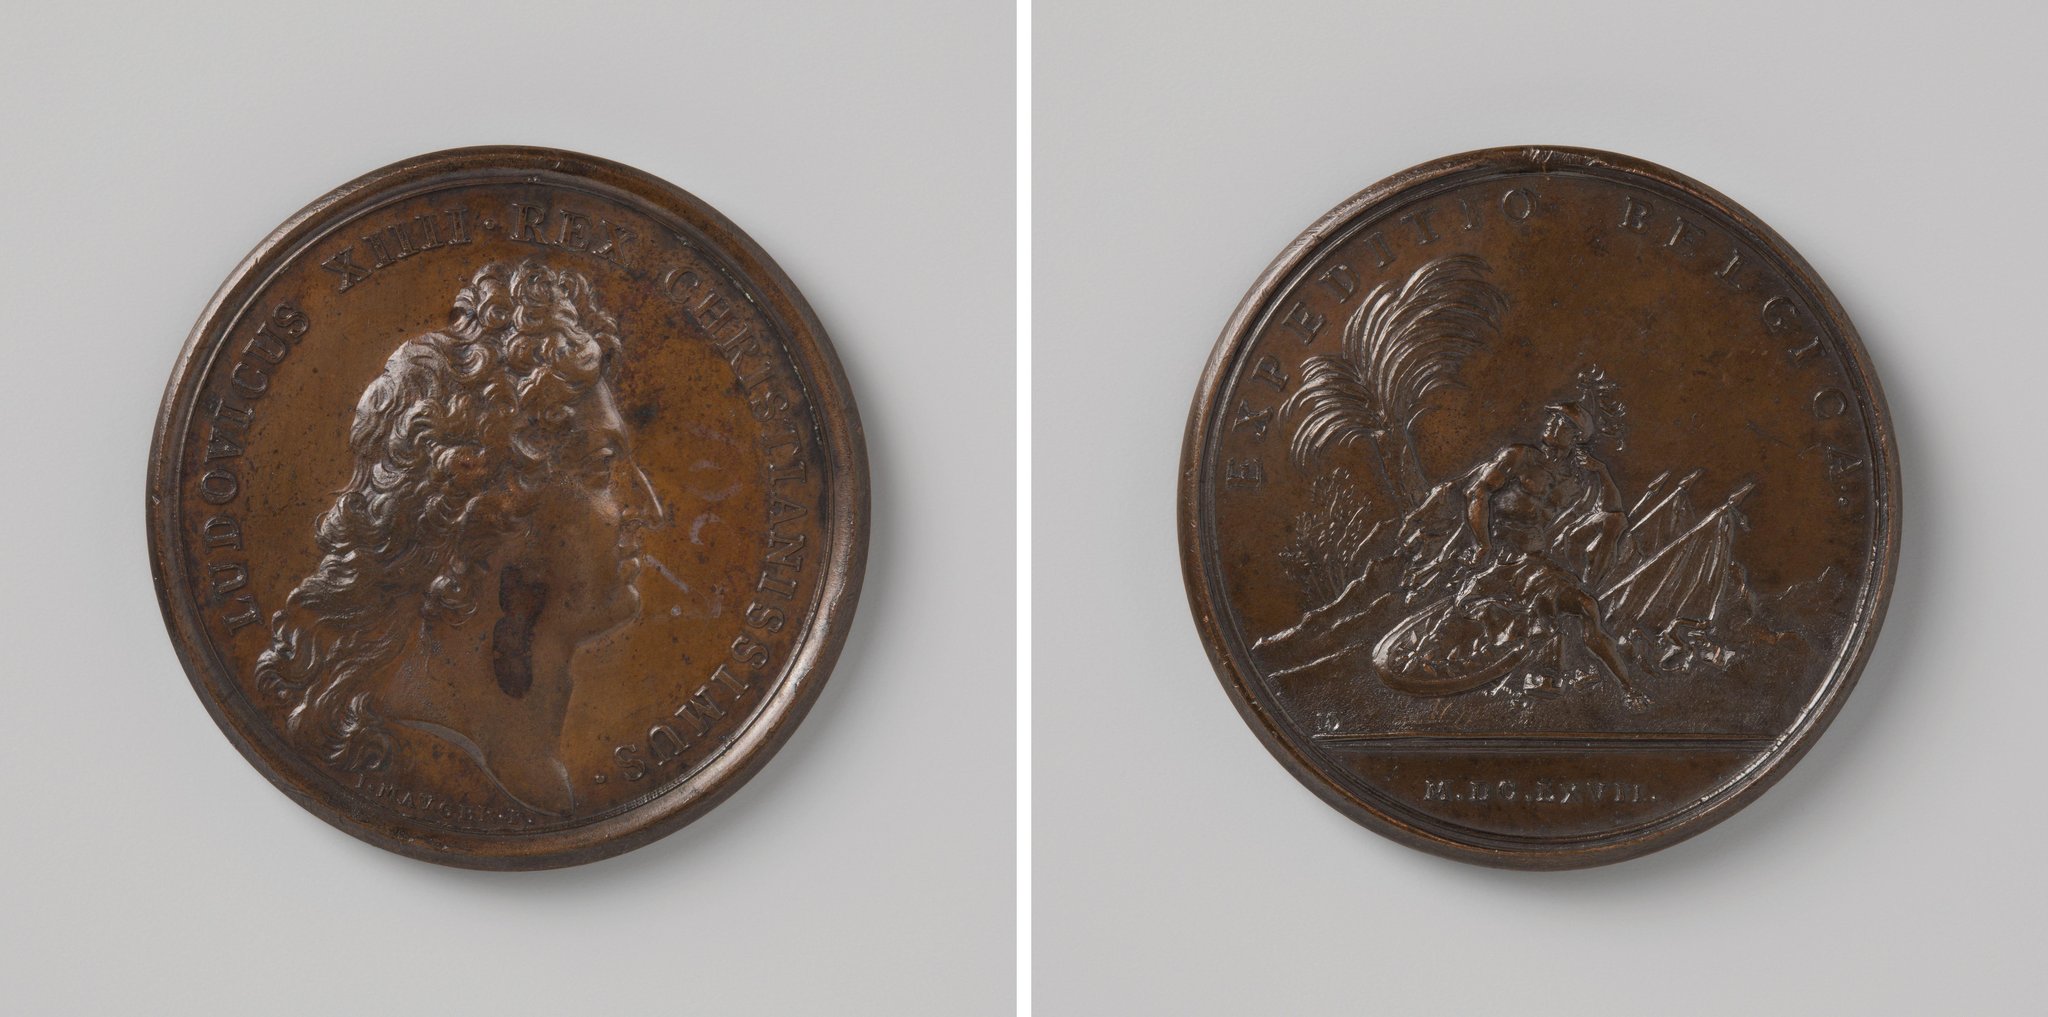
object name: history medal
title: Veldtocht in de Spaanse Nederlanden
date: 1699-1703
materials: bronze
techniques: striking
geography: paris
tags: lodewijk xiv (koning van frankrijk)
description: Bronzen penning. Voorzijde: borststuk jongeman (Lodewijk XIV) binnen omschrift. Keerzijde: gehelmde man zittend op vaandels onder boom binnen omschrift.